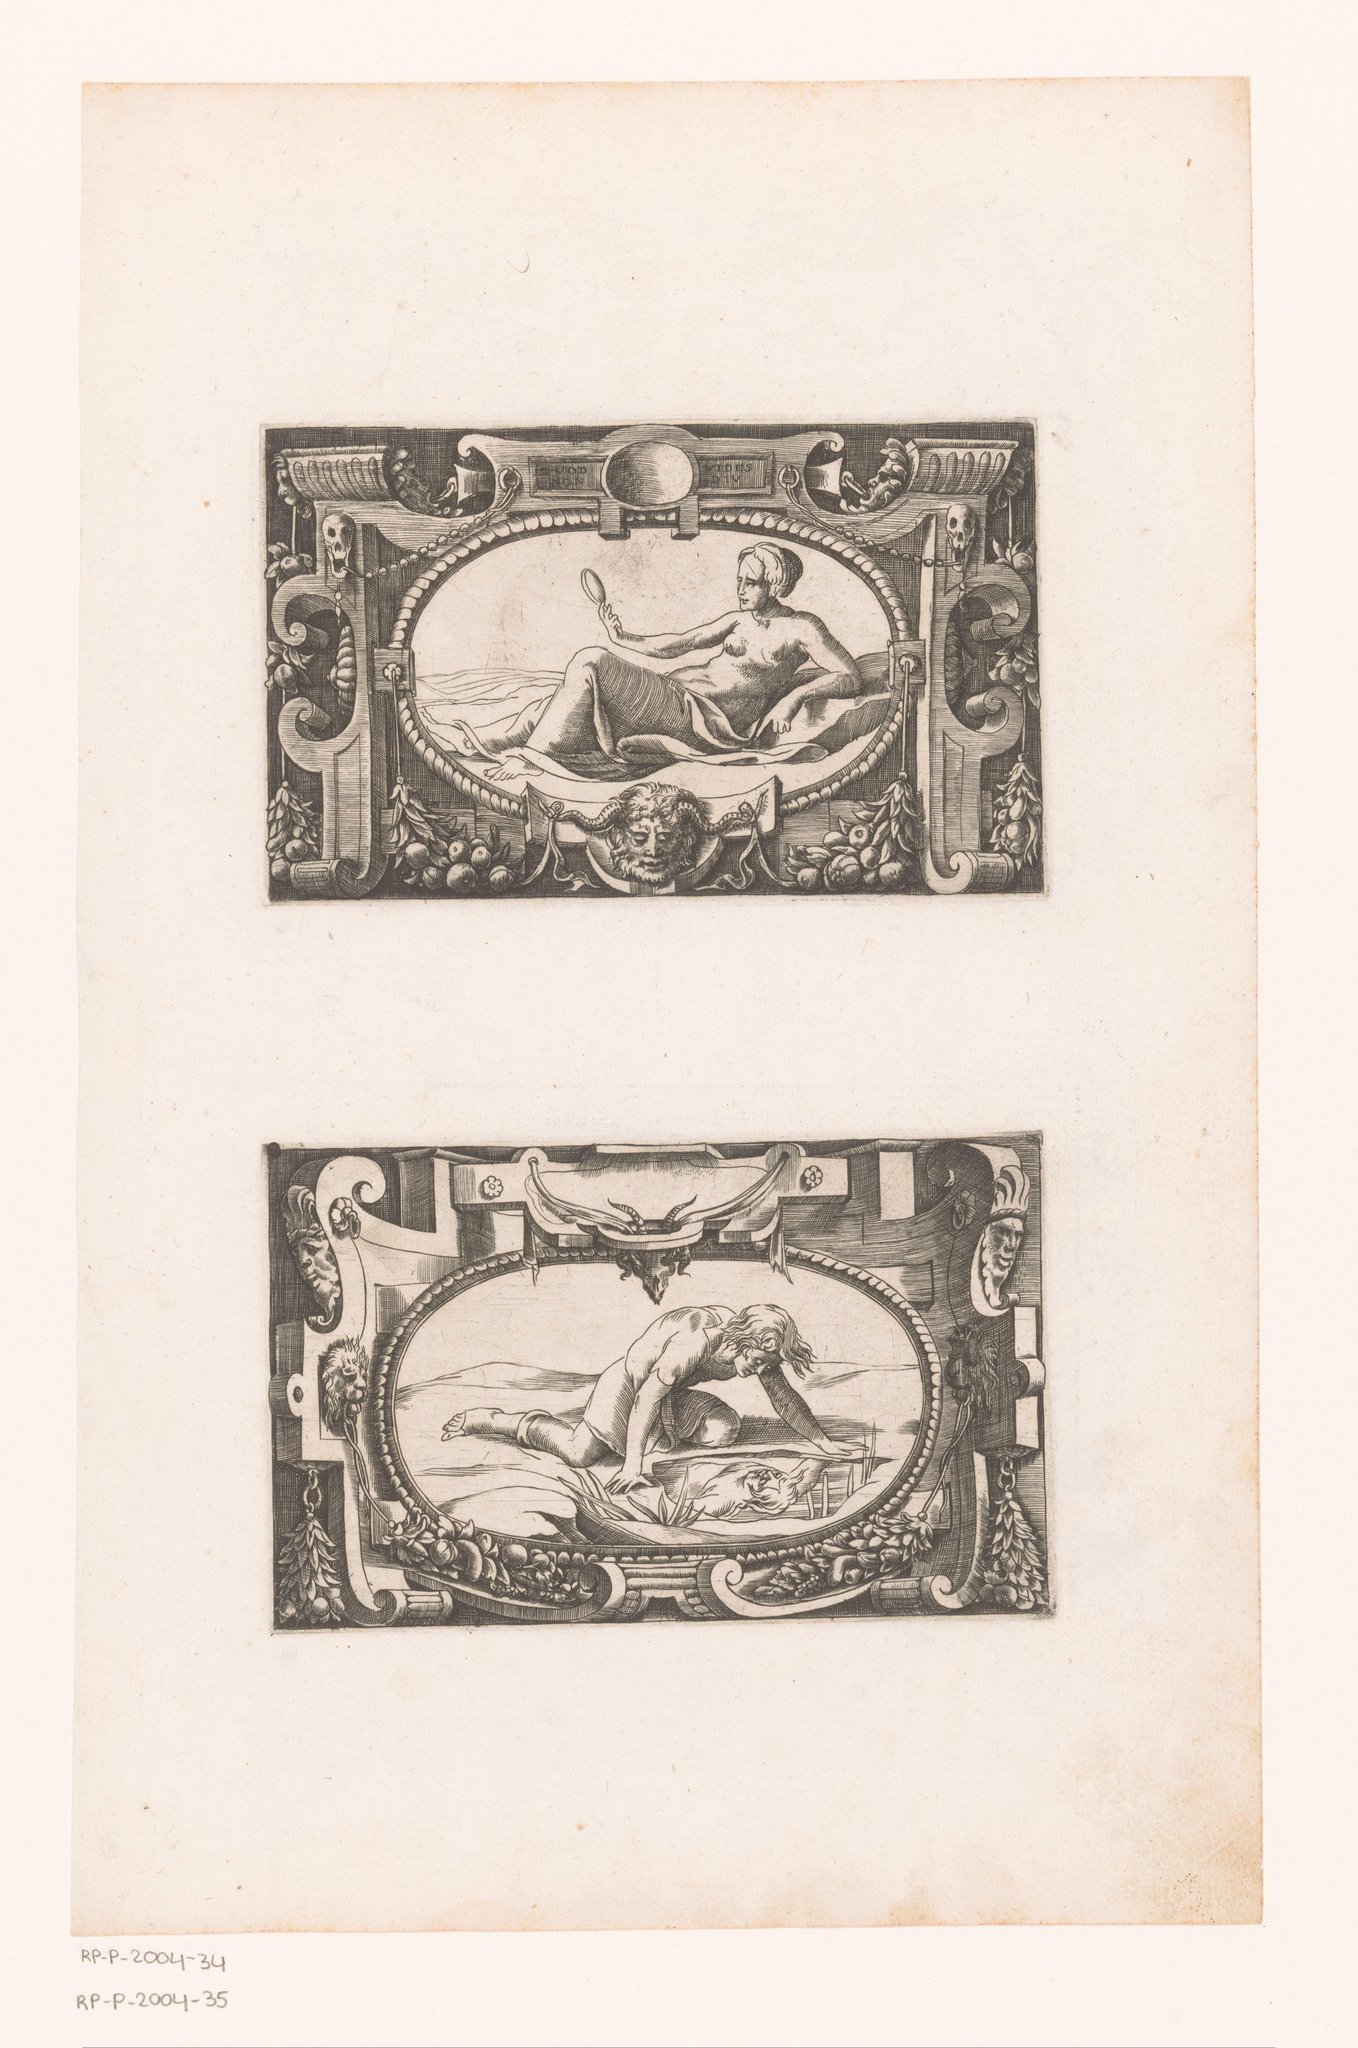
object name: print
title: Narcissus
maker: georges reverdy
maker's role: print maker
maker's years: 1450-1565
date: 1536-1569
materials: paper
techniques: engraving, etching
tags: narcissus, gazing in a fountain, falls in love with his own reflection; possibly the nymph echo peeps at the scene, ornament ~ cartouche, narcissus changed into a narcissus: when narcissus is pining away for the love of his image reflected from the water, he is changed into a narcissus (ovid, metamorphoses iii 510)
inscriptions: collector's mark: Lugt 2228, collector's mark: Lugt 2760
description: Prent maakt deel uit van een ongenummerde serie van drie prenten. Prent staat samen met RP-P-2004-34 op een onversneden blad.